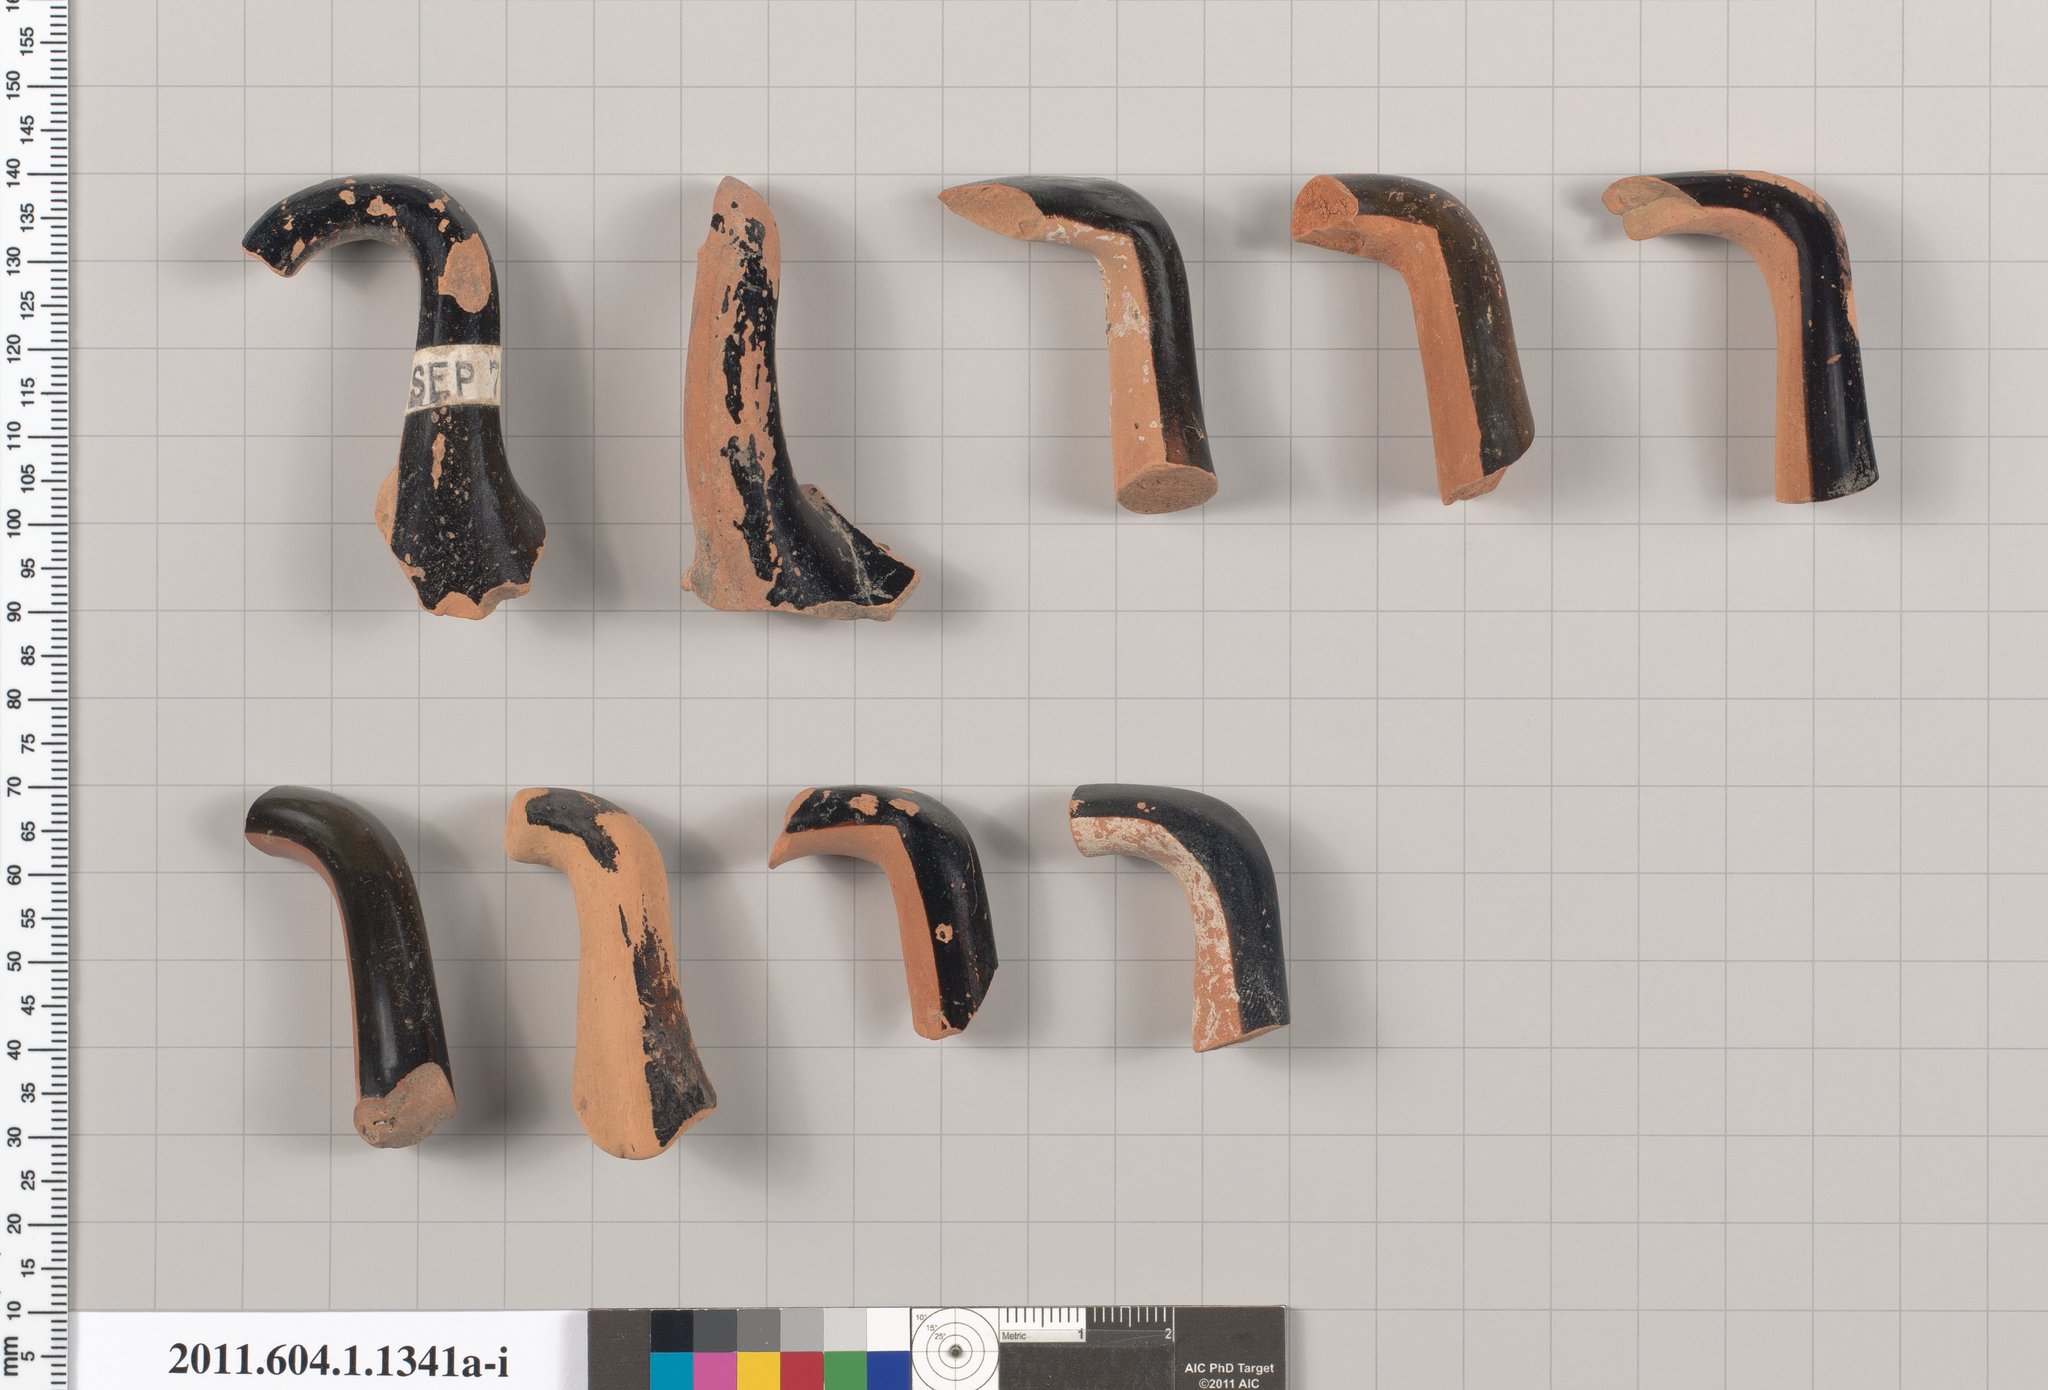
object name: kylix fragment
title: Terracotta fragments of kylikes (drinking cups)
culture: greek, attic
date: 500-401 BCE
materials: terracotta